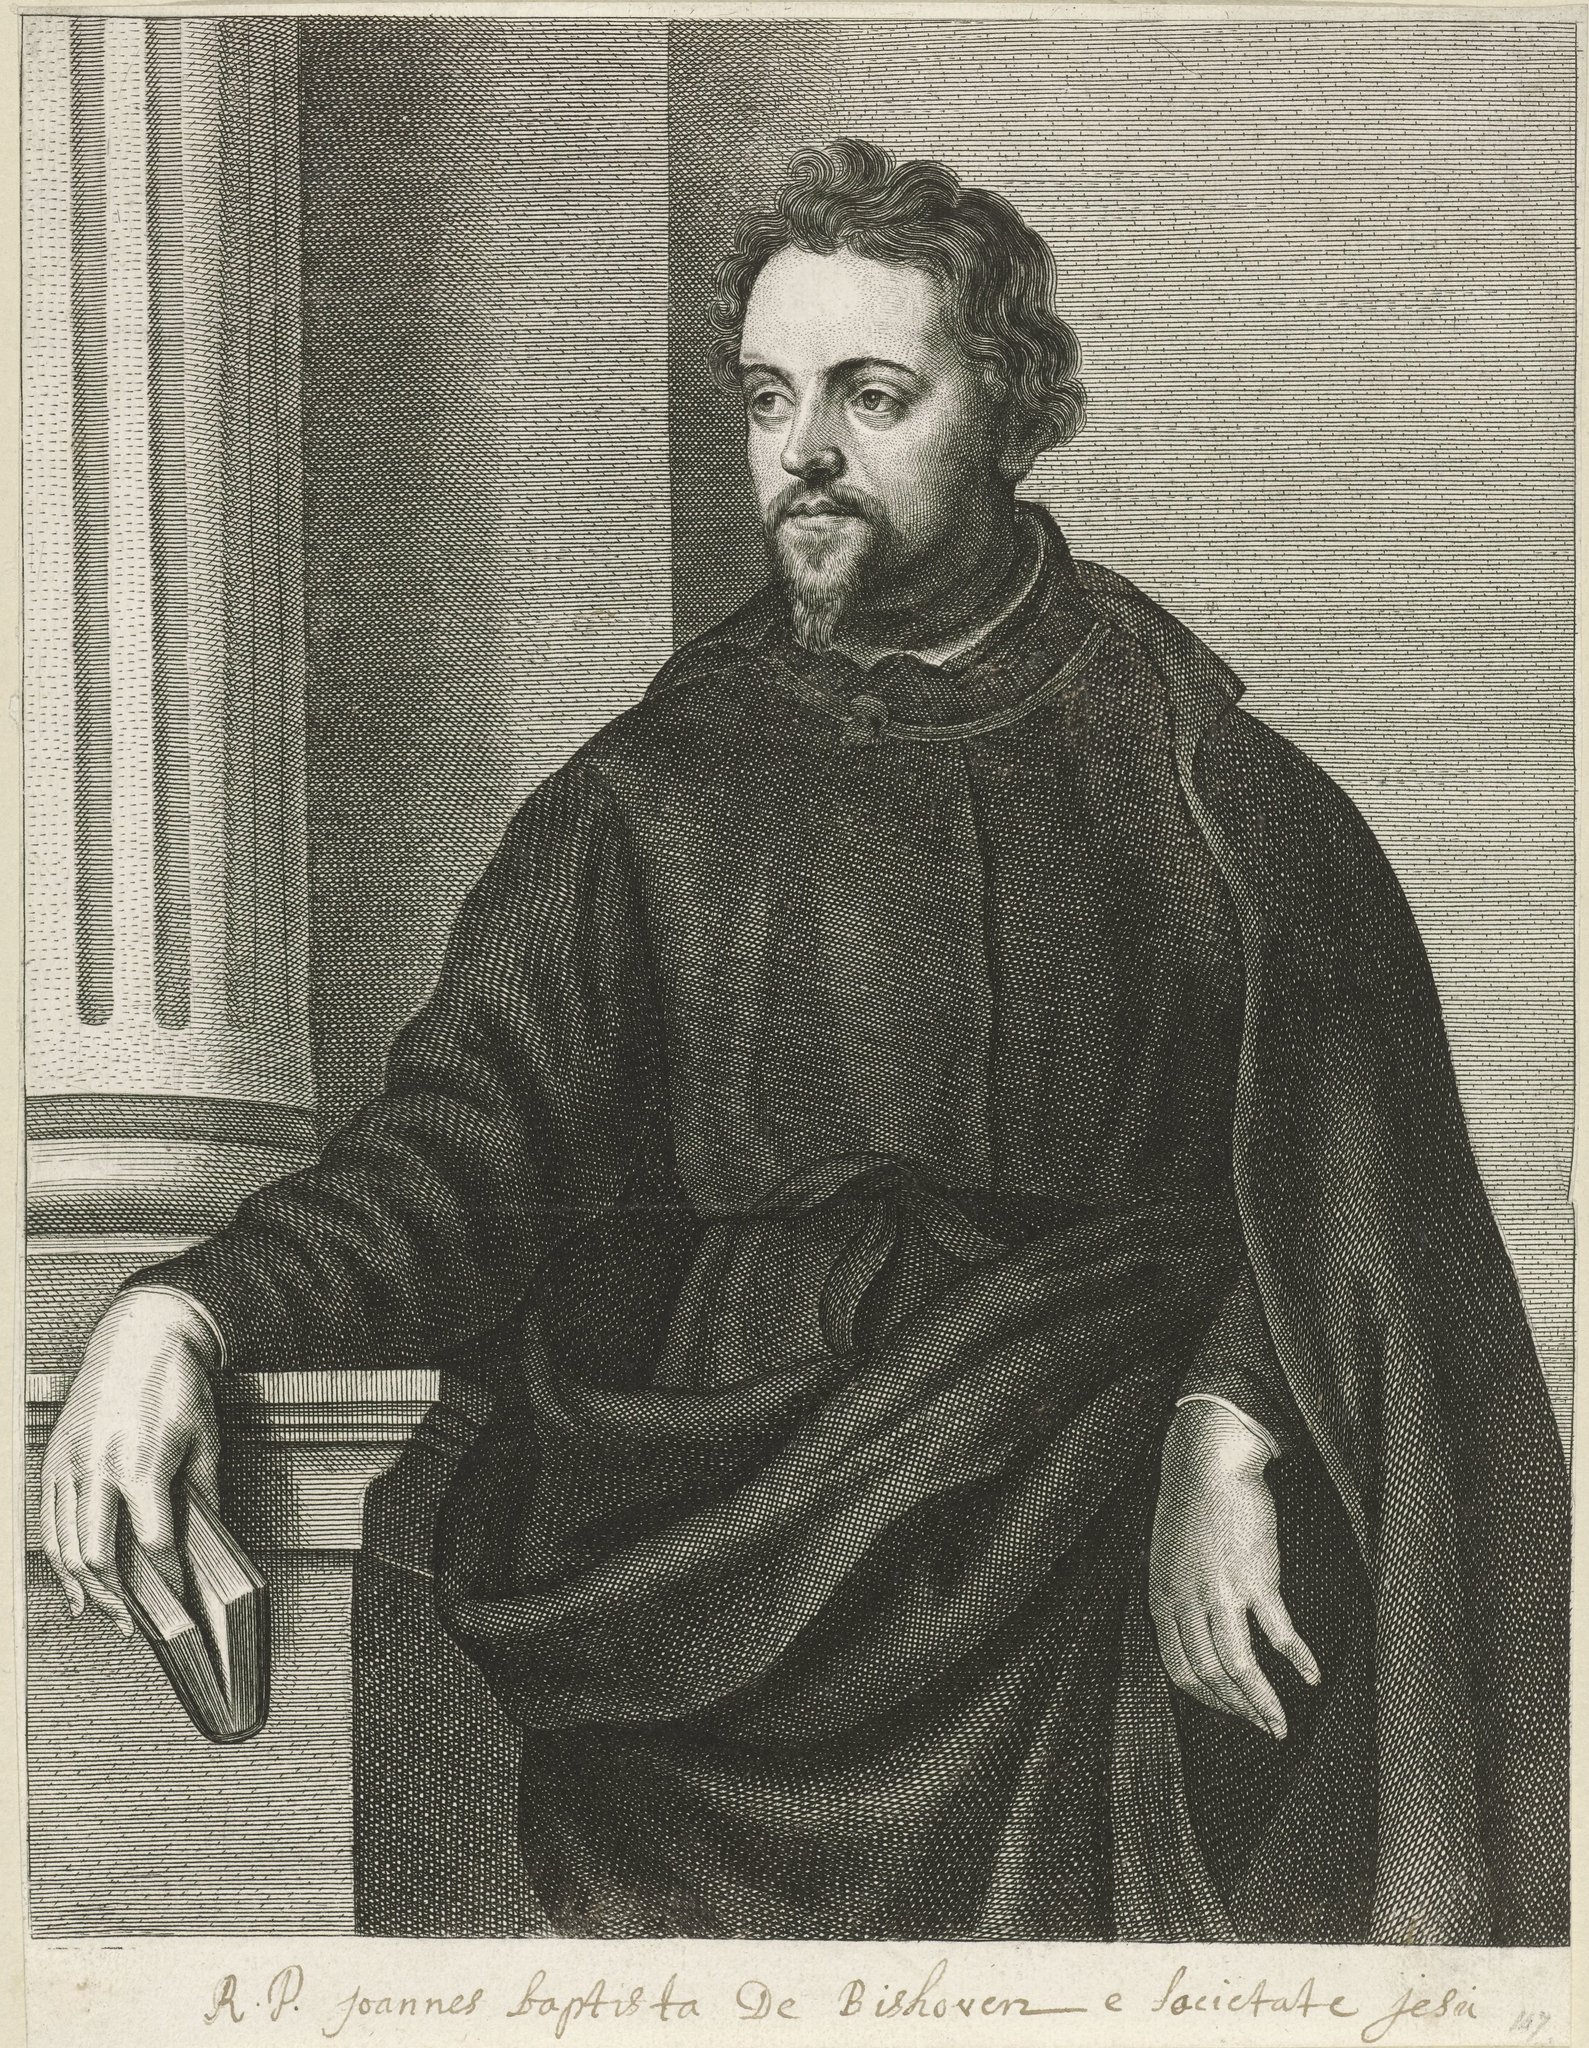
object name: print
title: Portret van Jan Baptist van Bisthoven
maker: adriaen lommelin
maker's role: print maker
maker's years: 1618-1675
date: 1630-1677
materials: paper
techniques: engraving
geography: antwerp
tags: rector, jezuïet, jan baptist van bisthoven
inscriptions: inscription: ‘R.P. Joannes Baptista De Bishoven _ e Societate Jesu’, collector's mark: Lugt 240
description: Portret van Jan Baptist van Bisthoven, Jezuïet en rector van het college te Aalst.